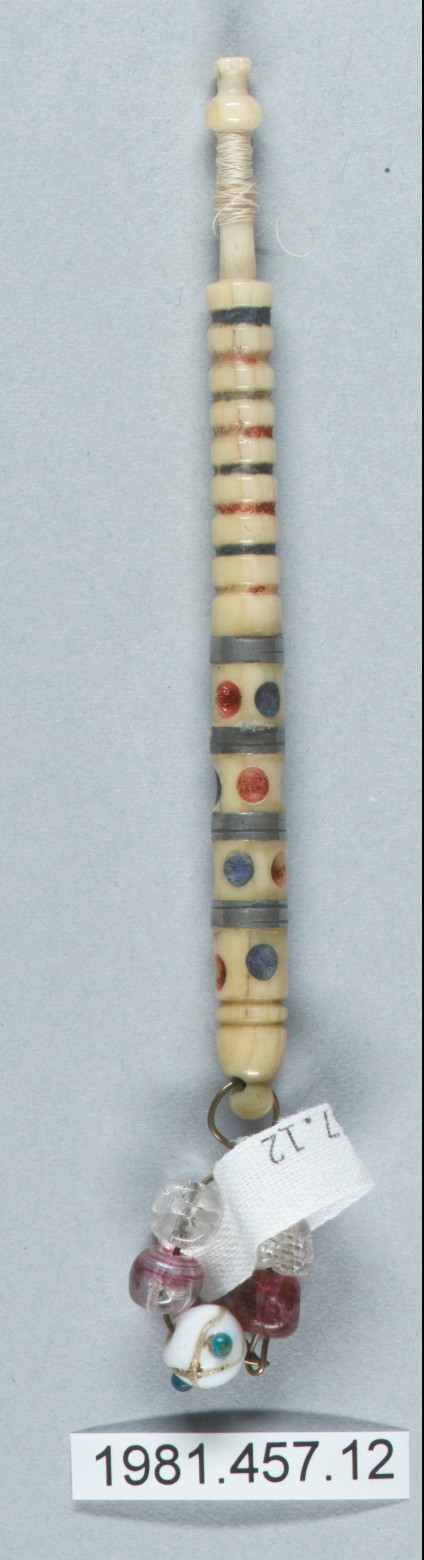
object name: bobbin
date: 1840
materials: wood